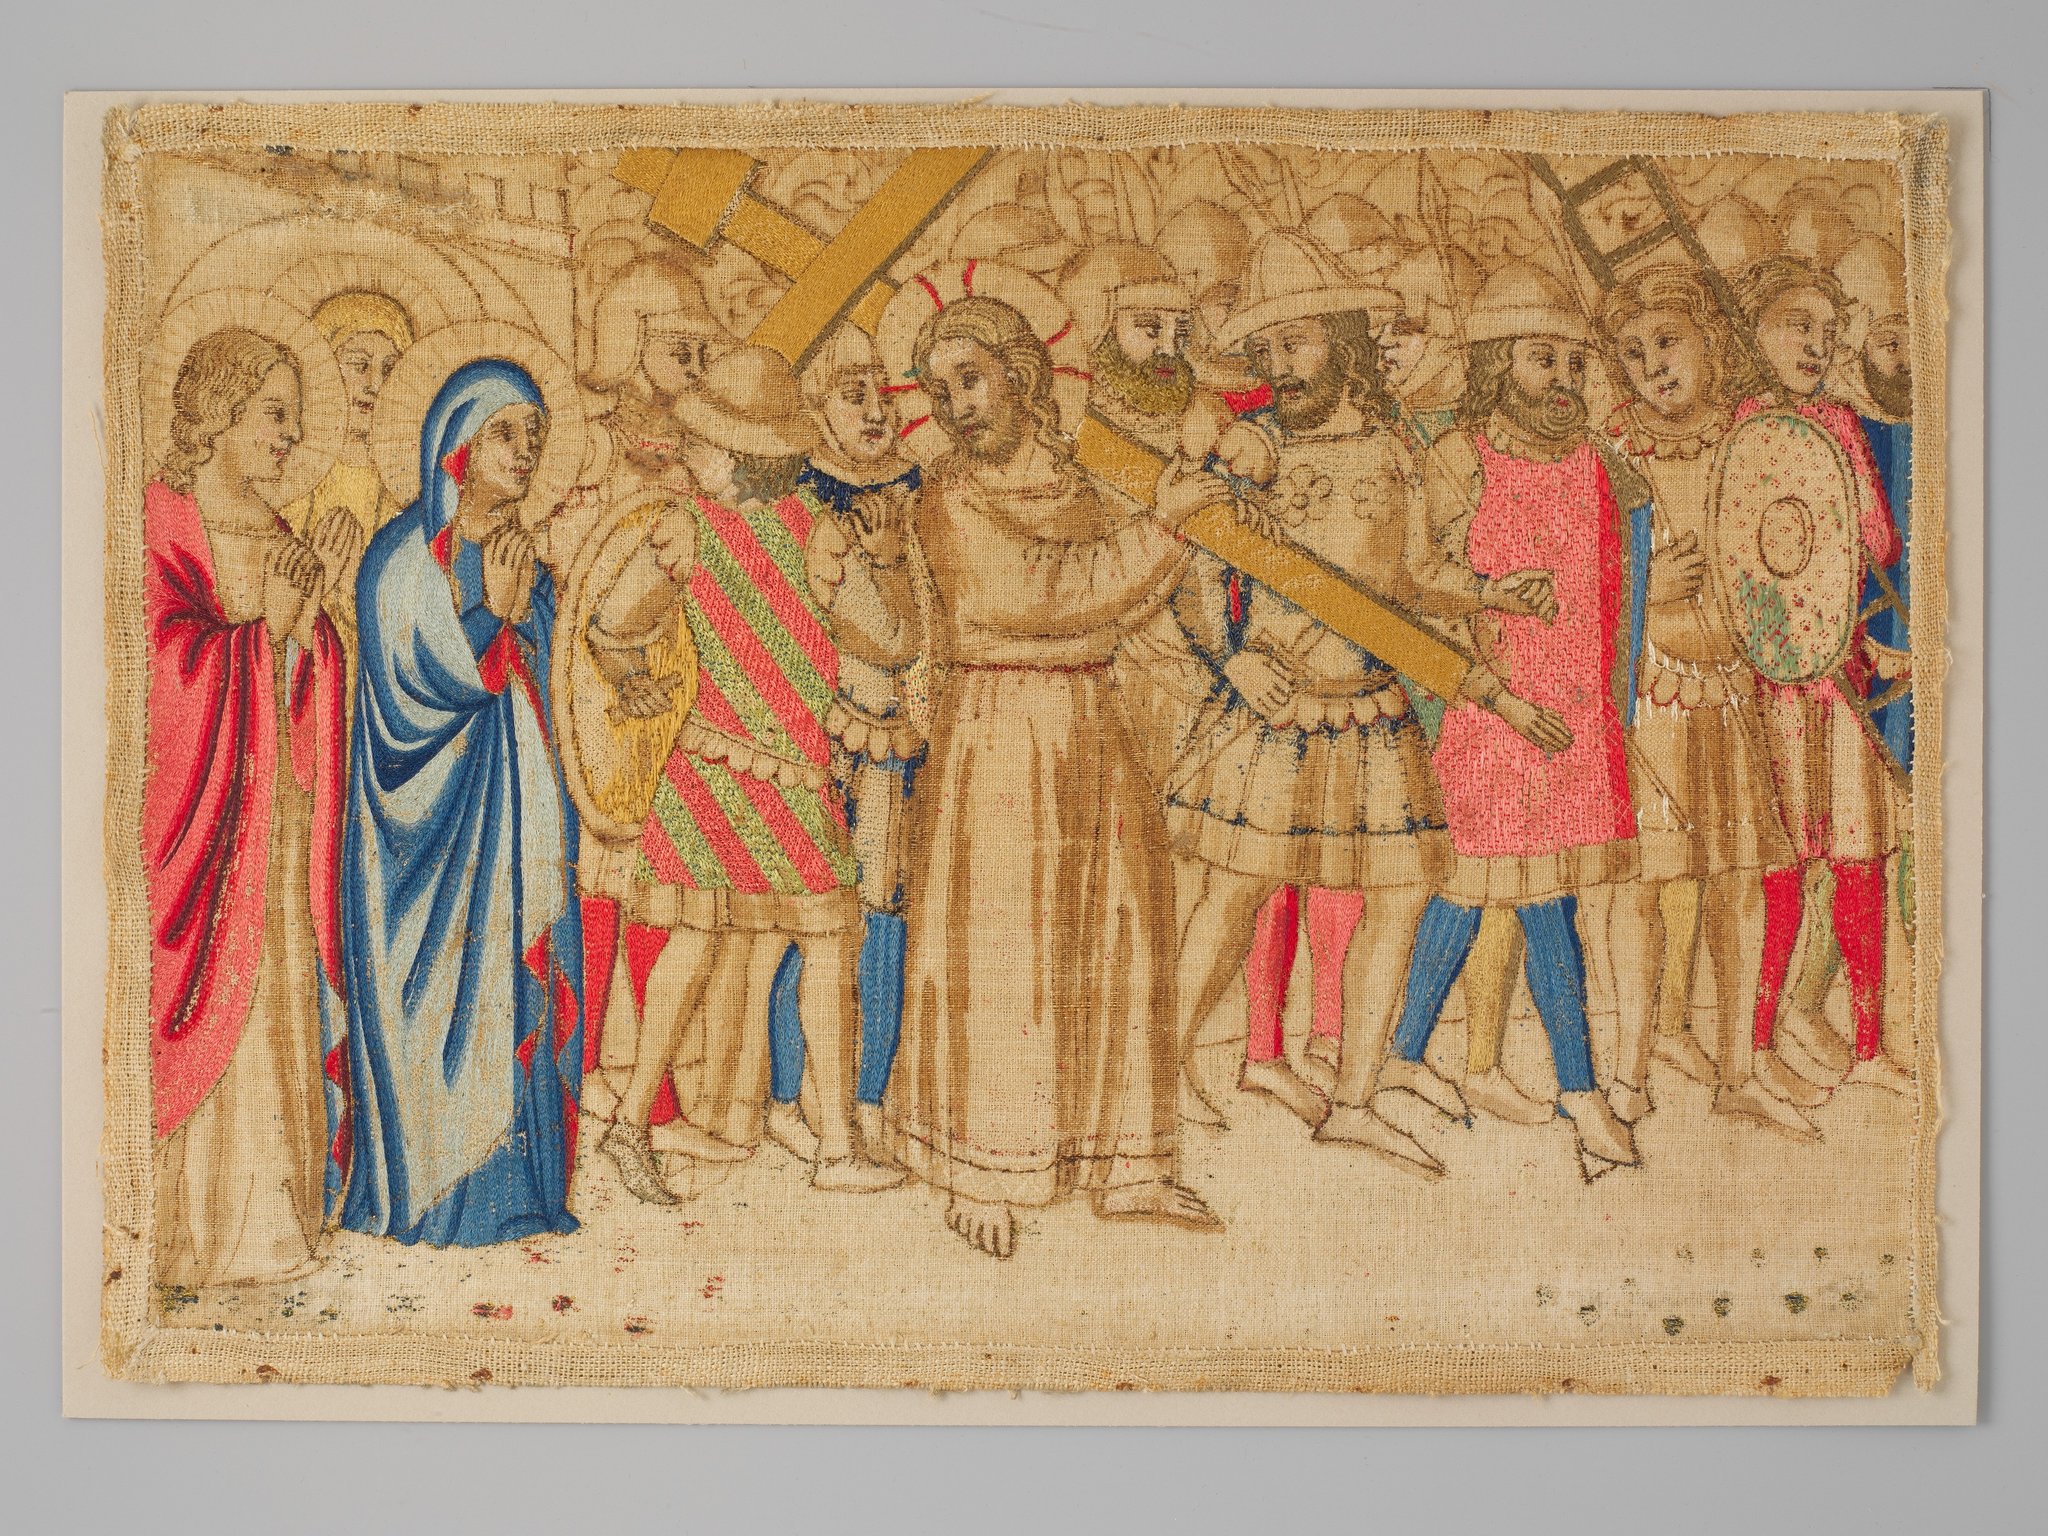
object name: panel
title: Christ Carrying the Cross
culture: italian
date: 1301-1400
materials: canvas, silk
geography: italy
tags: men,women,cross